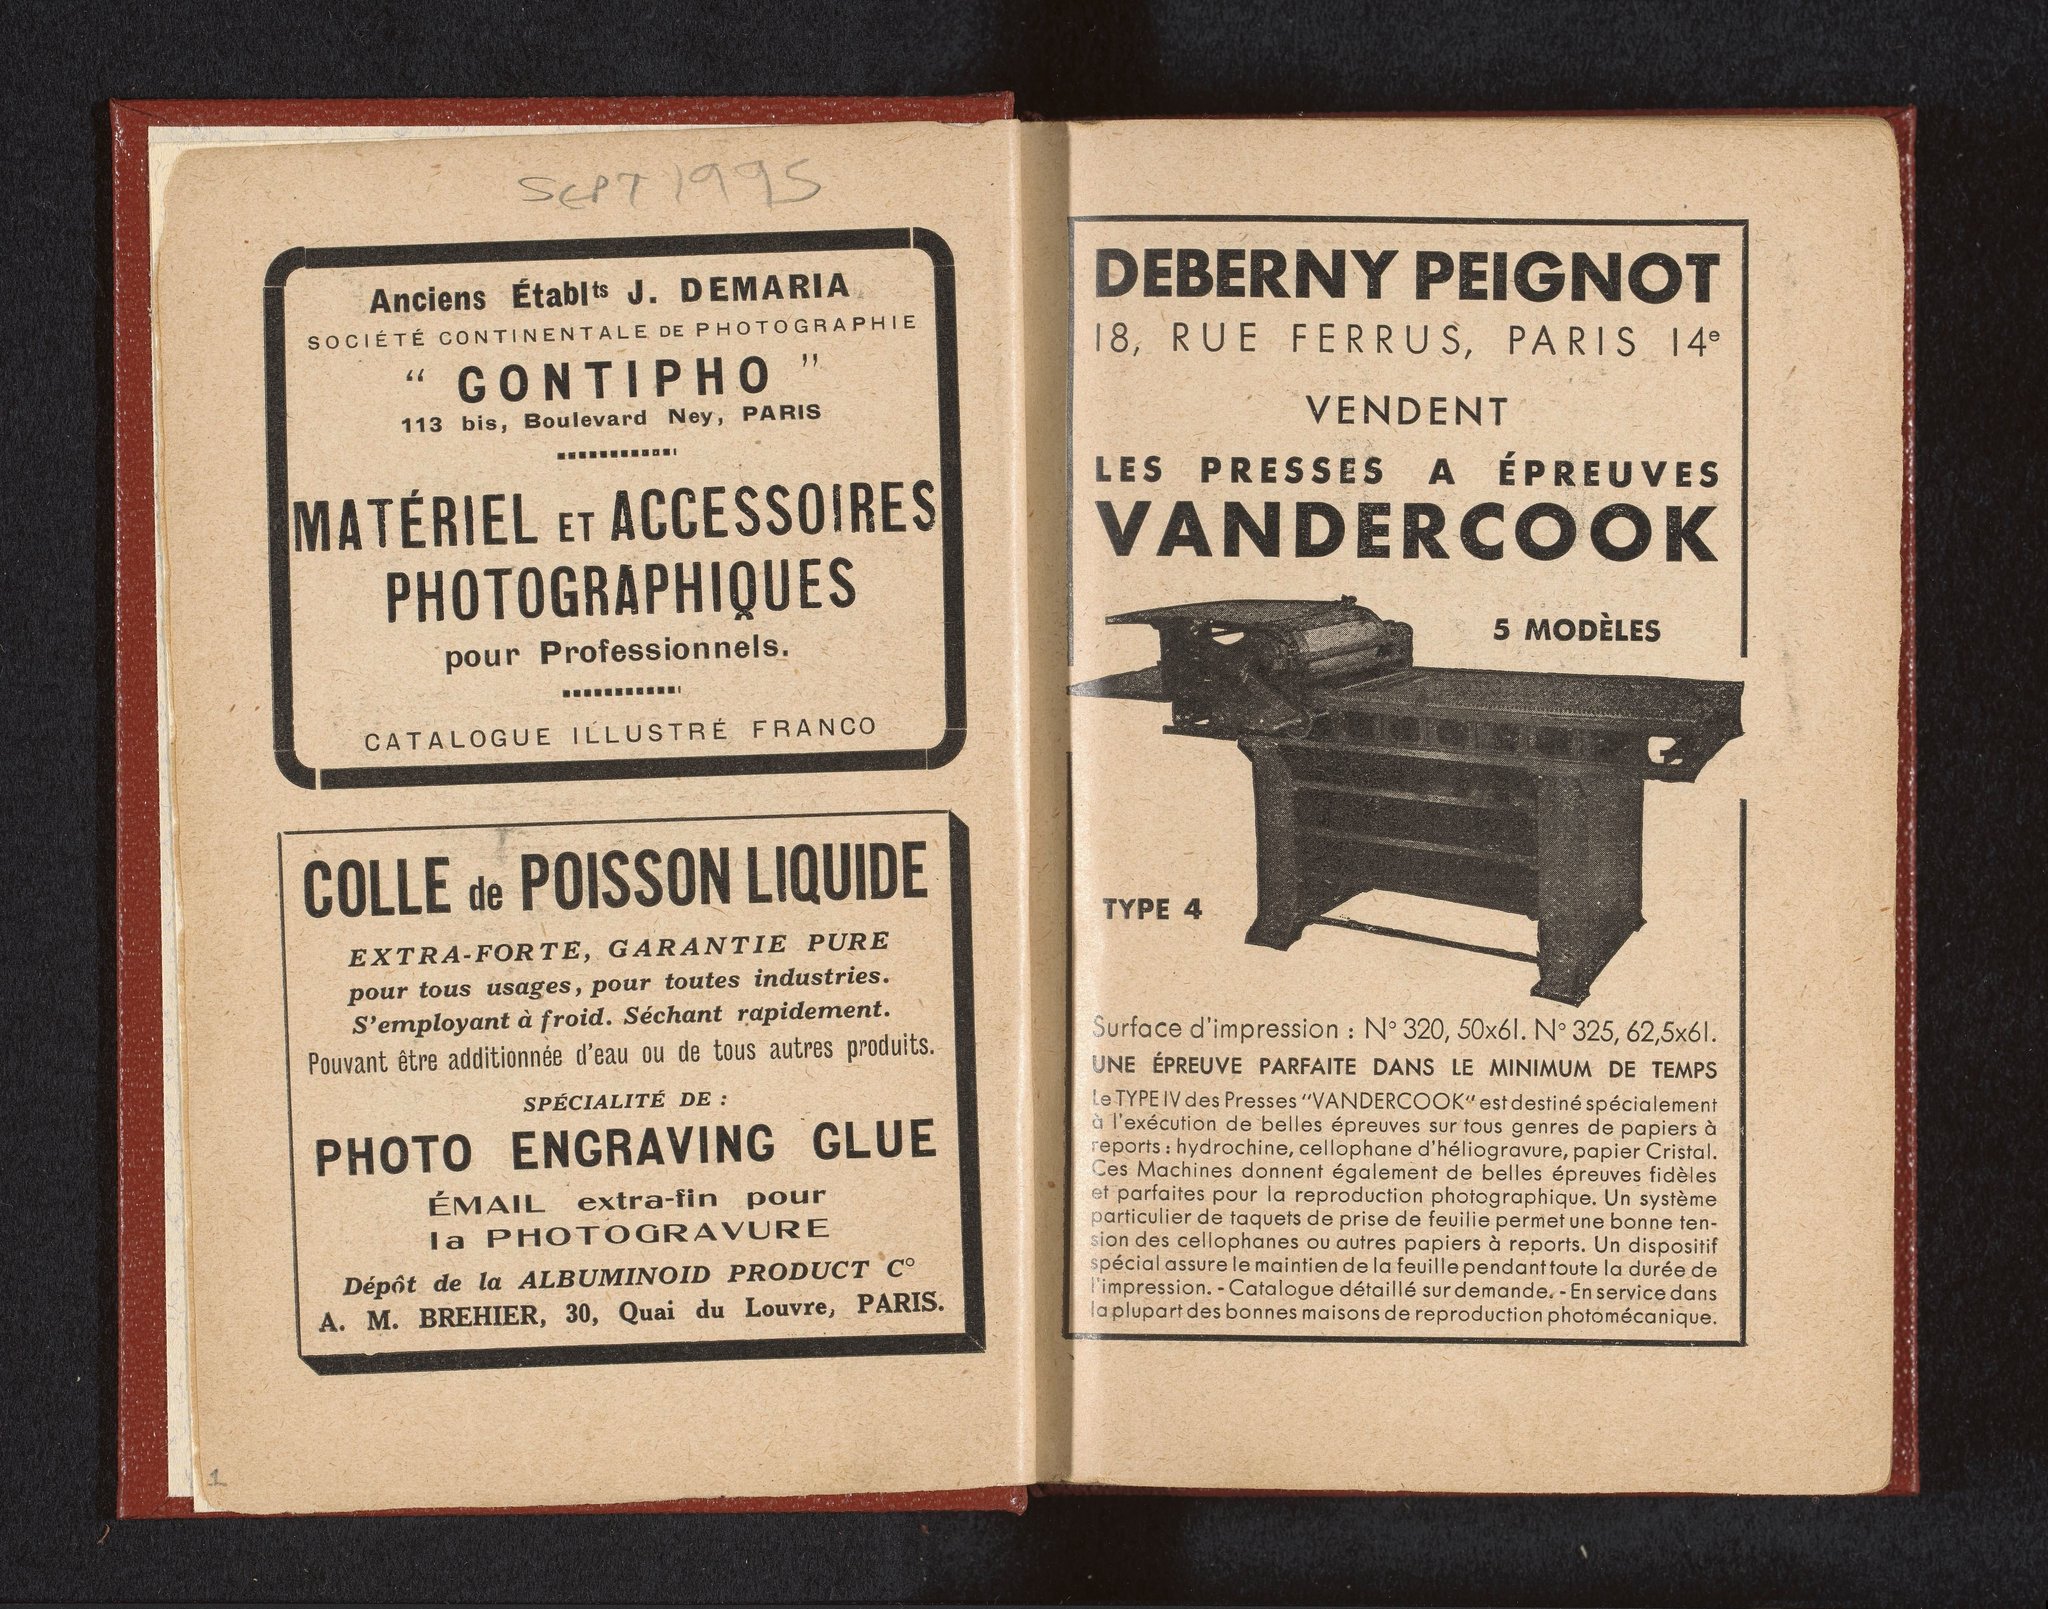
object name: photomechanical print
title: Drukpers voor een fotomechanisch procedé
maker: Anonymous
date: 1922-1932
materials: paper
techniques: autotype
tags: photographic apparatus, printing press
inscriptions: inscription: ‘Deberny Peignot 18, Rue Ferrus, Paris 14e vendent les presses a épreuves Vandercook 5 modèles type 4’